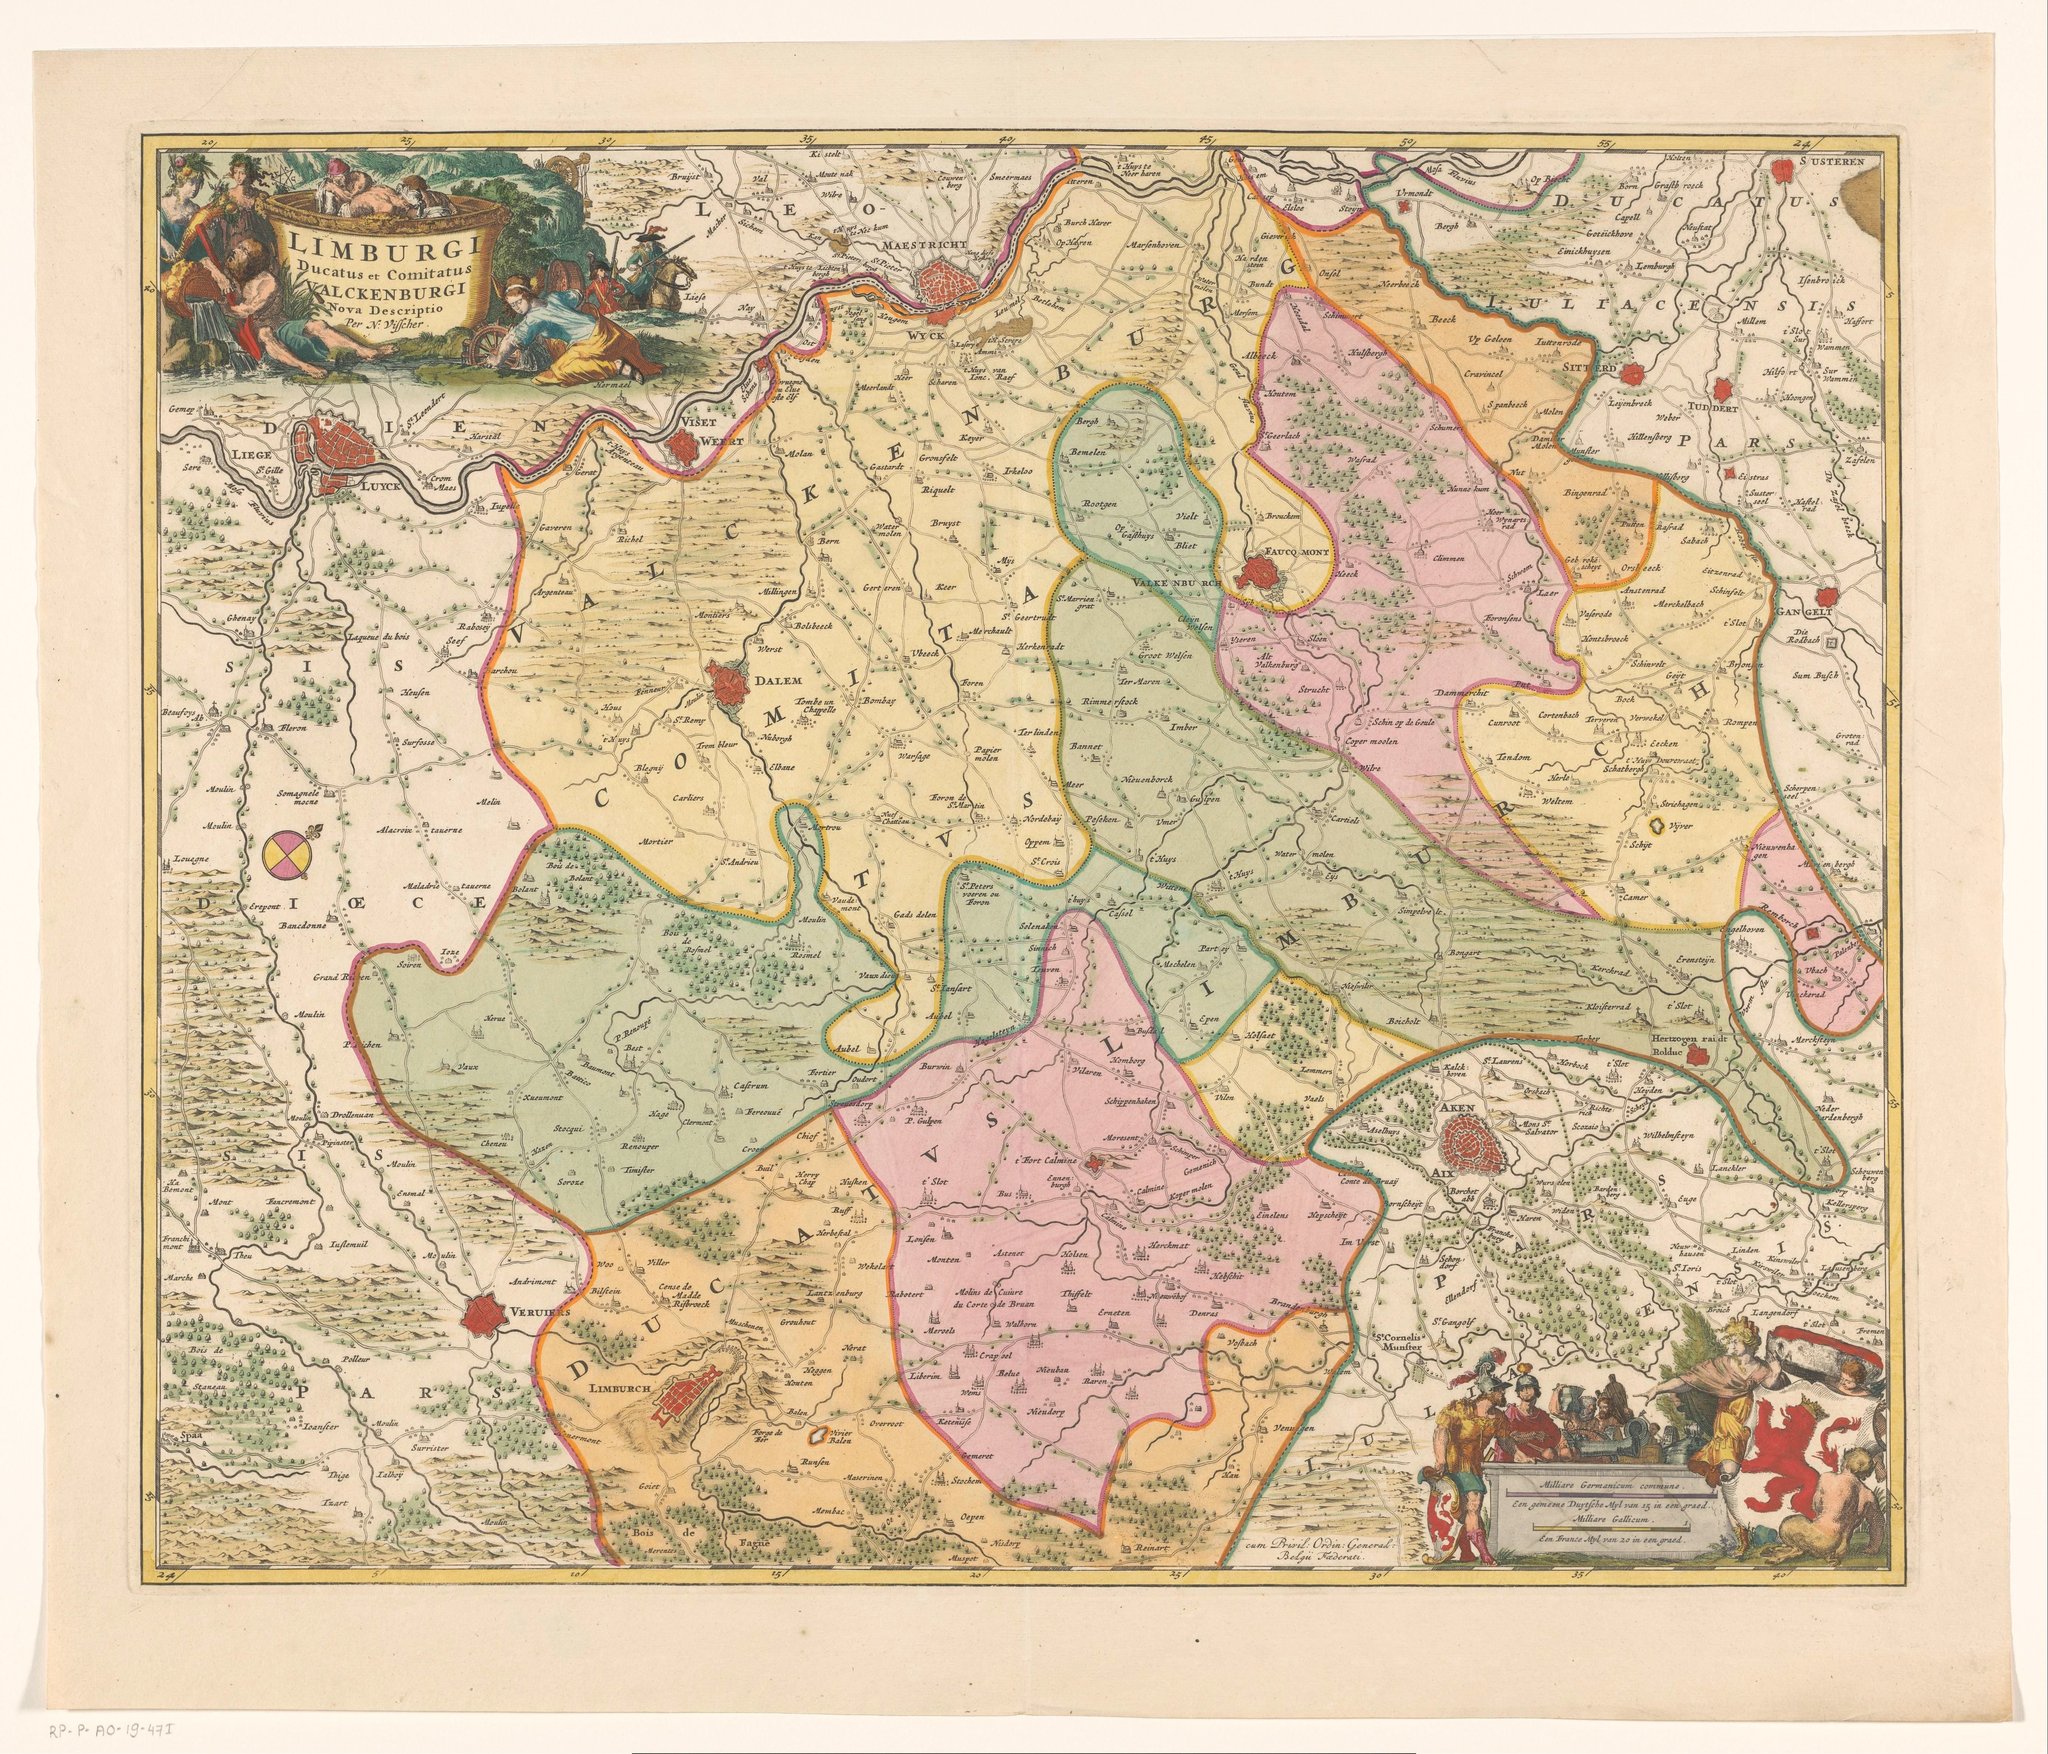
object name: map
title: Kaart van het hertogdom Limburg en het graafschap Valkenburg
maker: Anonymous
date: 1677-1720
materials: paper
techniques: engraving, etching, hand coloring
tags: maps of separate countries or regions, river personified, 'fiumi' (ripa) - hh - ideal landscapes, coat of arms (as symbol of the state, etc.) (+ province; provincial), bath-tub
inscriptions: collector's mark: Lugt 2228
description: Kaart van het hertogdom Limburg en het graafschap Valkenburg. Linksboven de titelcartouche. Rechtsonder een cartouche met het wapen van het hertogdom Limburg en twee schaalstokken: Een gemeene Duytsche Myl van 15 in een graed / Een France Myl van 20 in een graed. De kaart is voorzien van een gradenverdeling langs de randen.